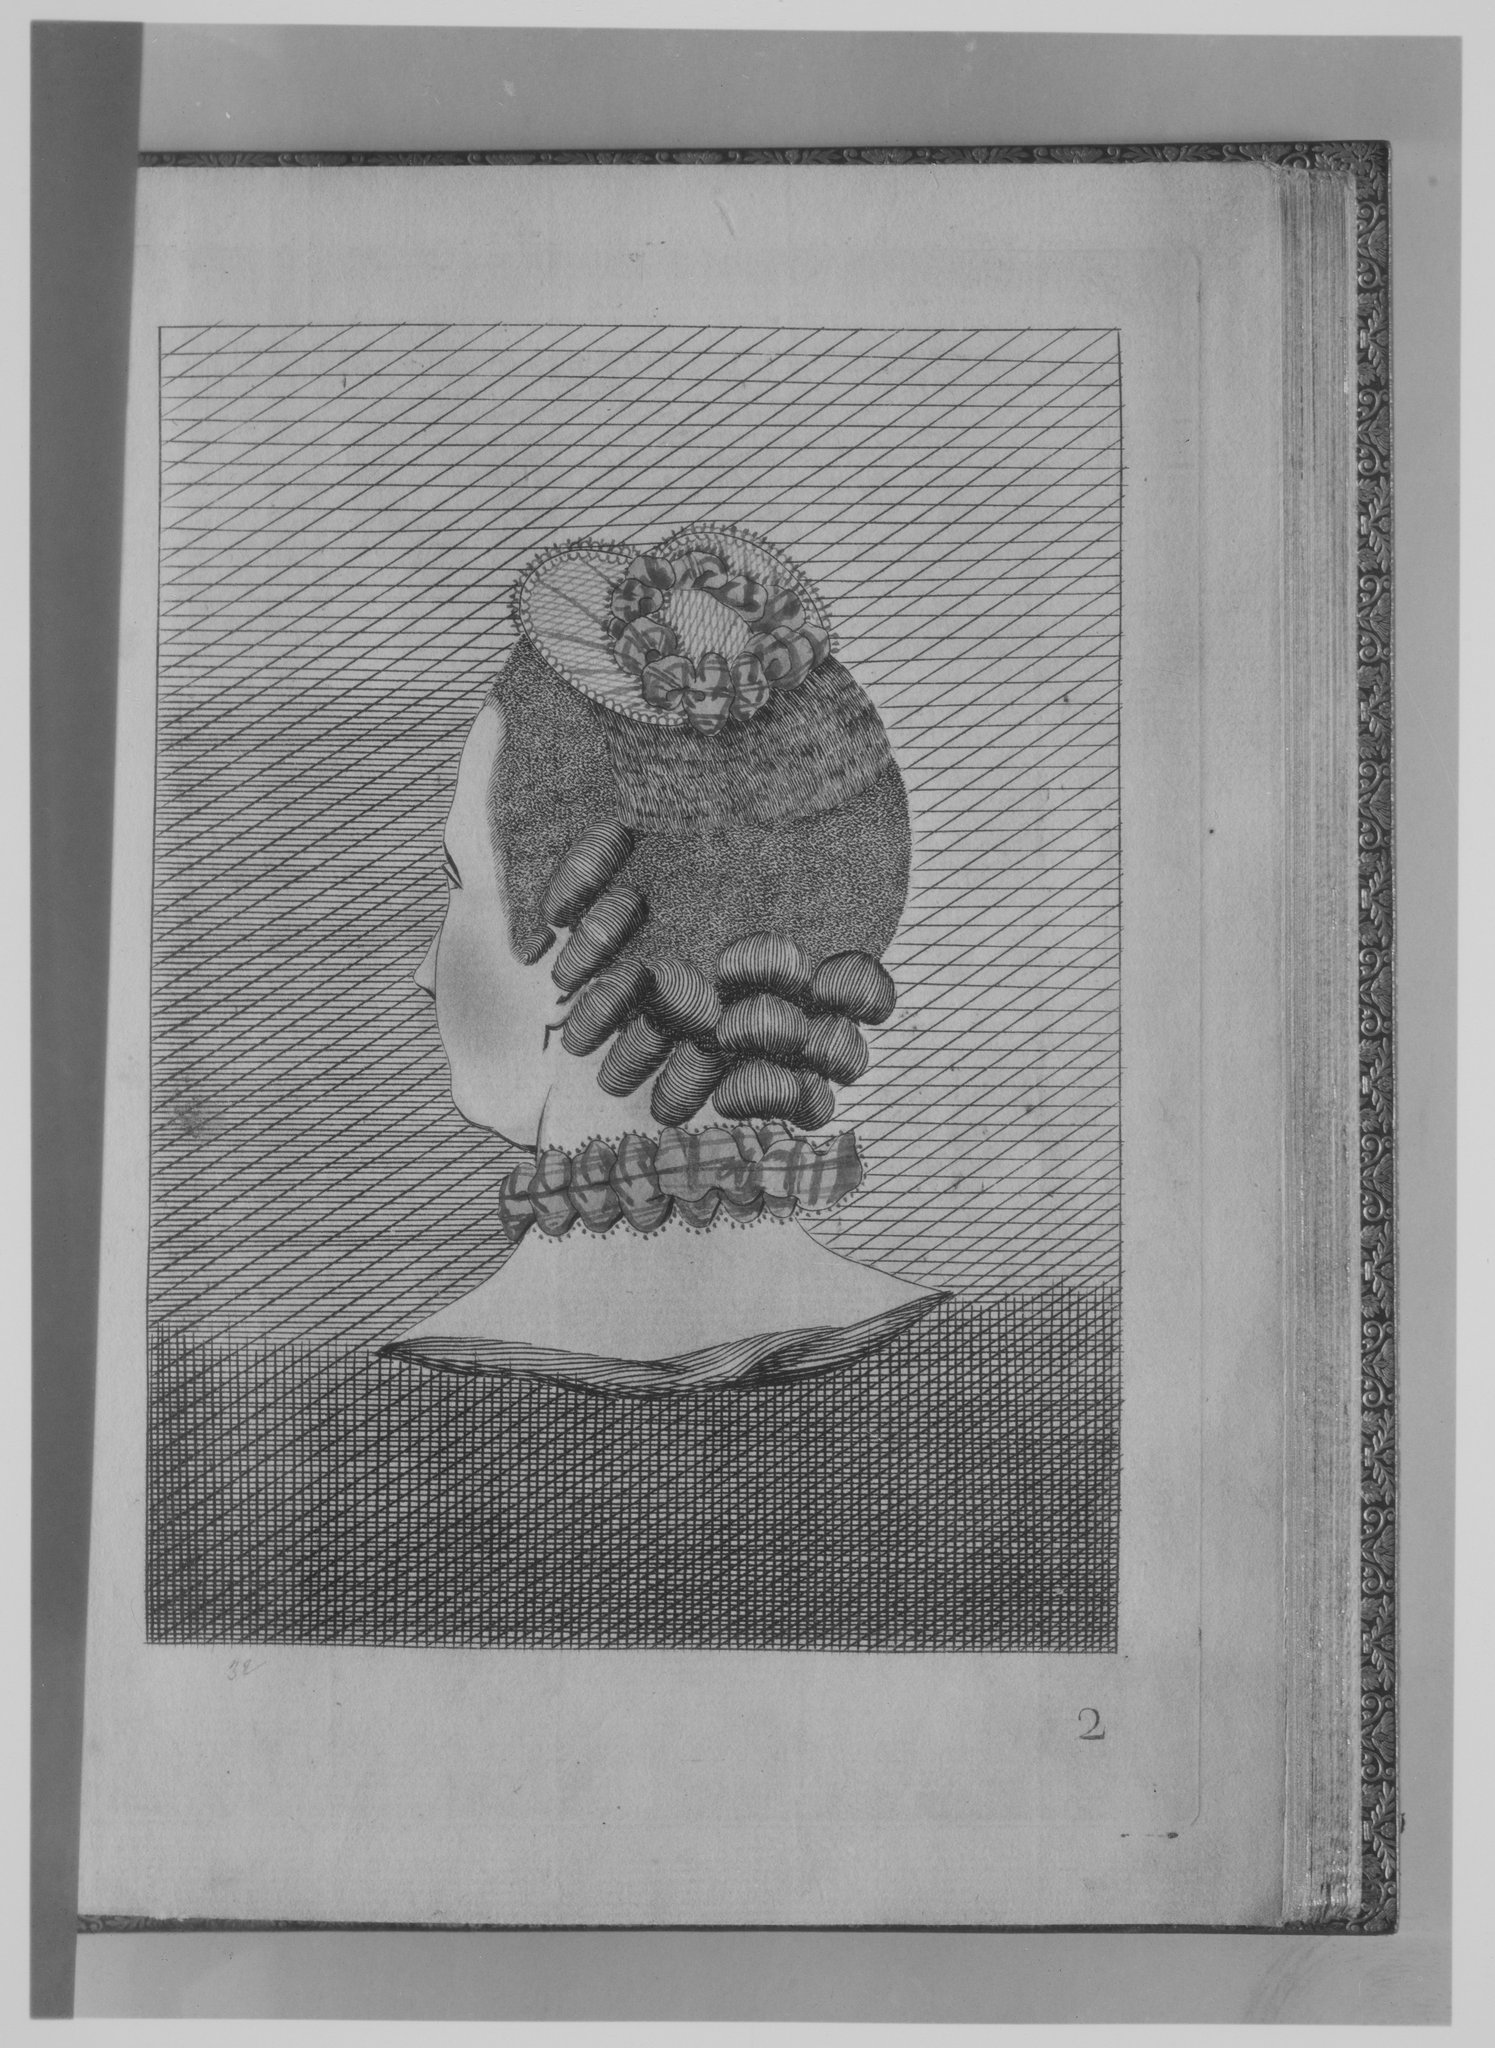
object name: book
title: L'Art de la Coeffure des Dames Françoises...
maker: le sieur legros de rumigny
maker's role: author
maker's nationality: french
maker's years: 18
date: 1767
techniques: engraving, hand coloring, woodcut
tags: heads,women